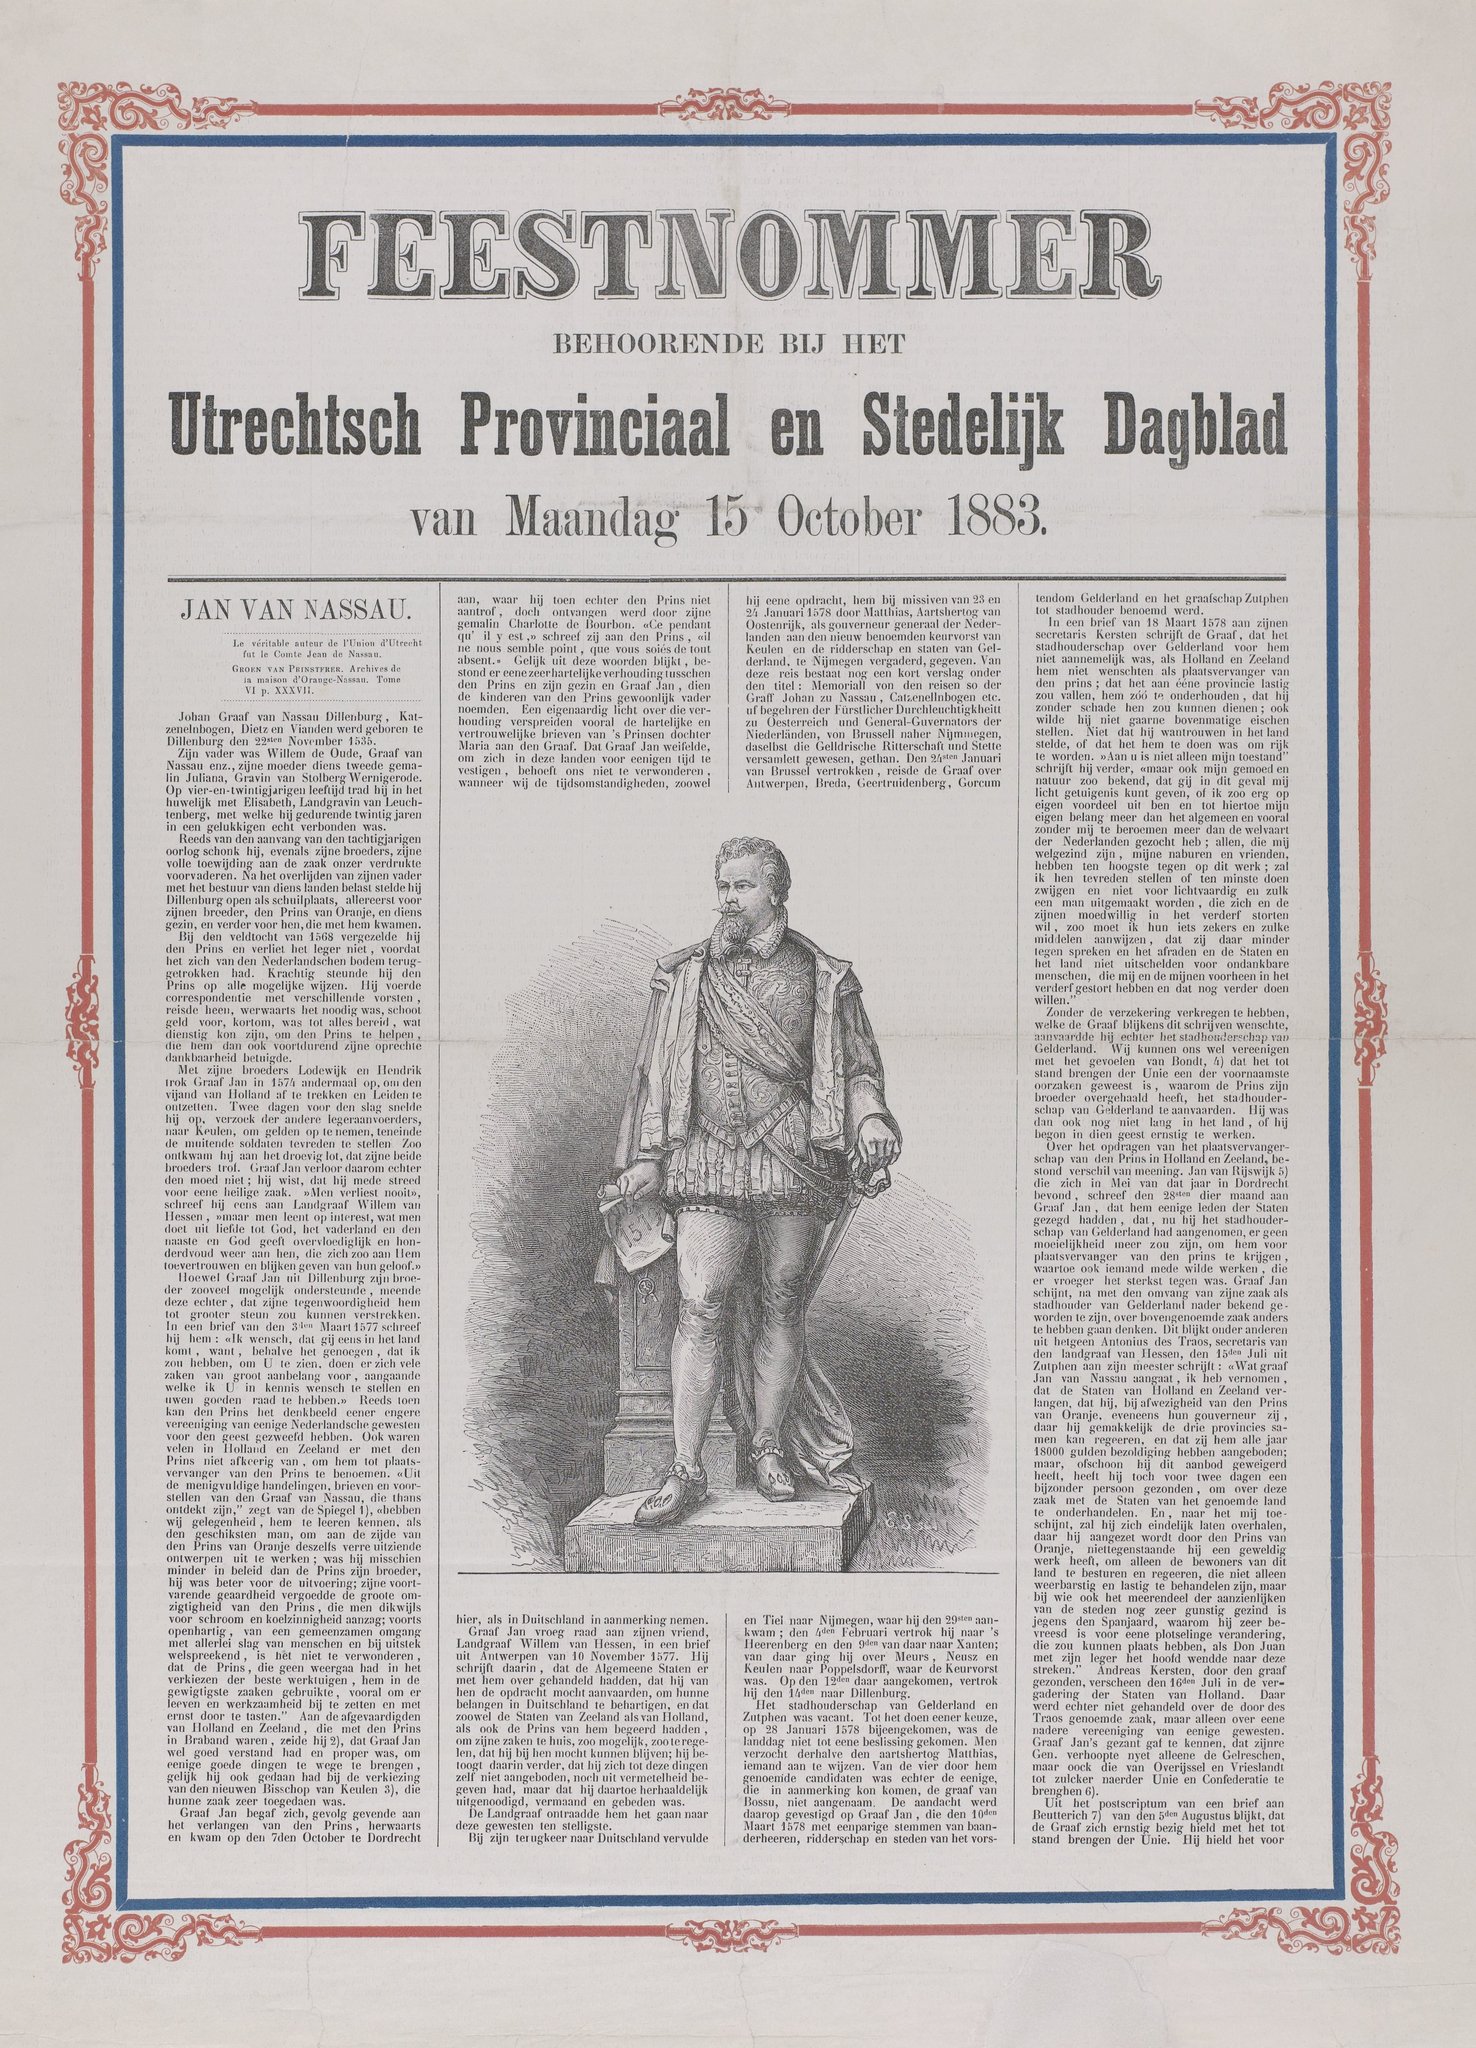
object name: newspaper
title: Feestnommer behoorende bij het Utrechtsch Procinciaal en Stedelijk Dagblad van Maandag 15 October 1883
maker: monogrammist es (19e eeuw)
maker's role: print maker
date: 1883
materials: paper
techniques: letterpress printing, engraving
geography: netherlands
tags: monument, statue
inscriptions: date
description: Feestnummer ter ere van het standbeeld van Johan VI. In het midden het standbeeld van Johan VI door Jean Theodor Stracké op het Domplein te Utrecht. Daar omheen vier kolommen met Nederlandse tekst in boekdruk. Geheel in een geornamenteerde rechthoek.